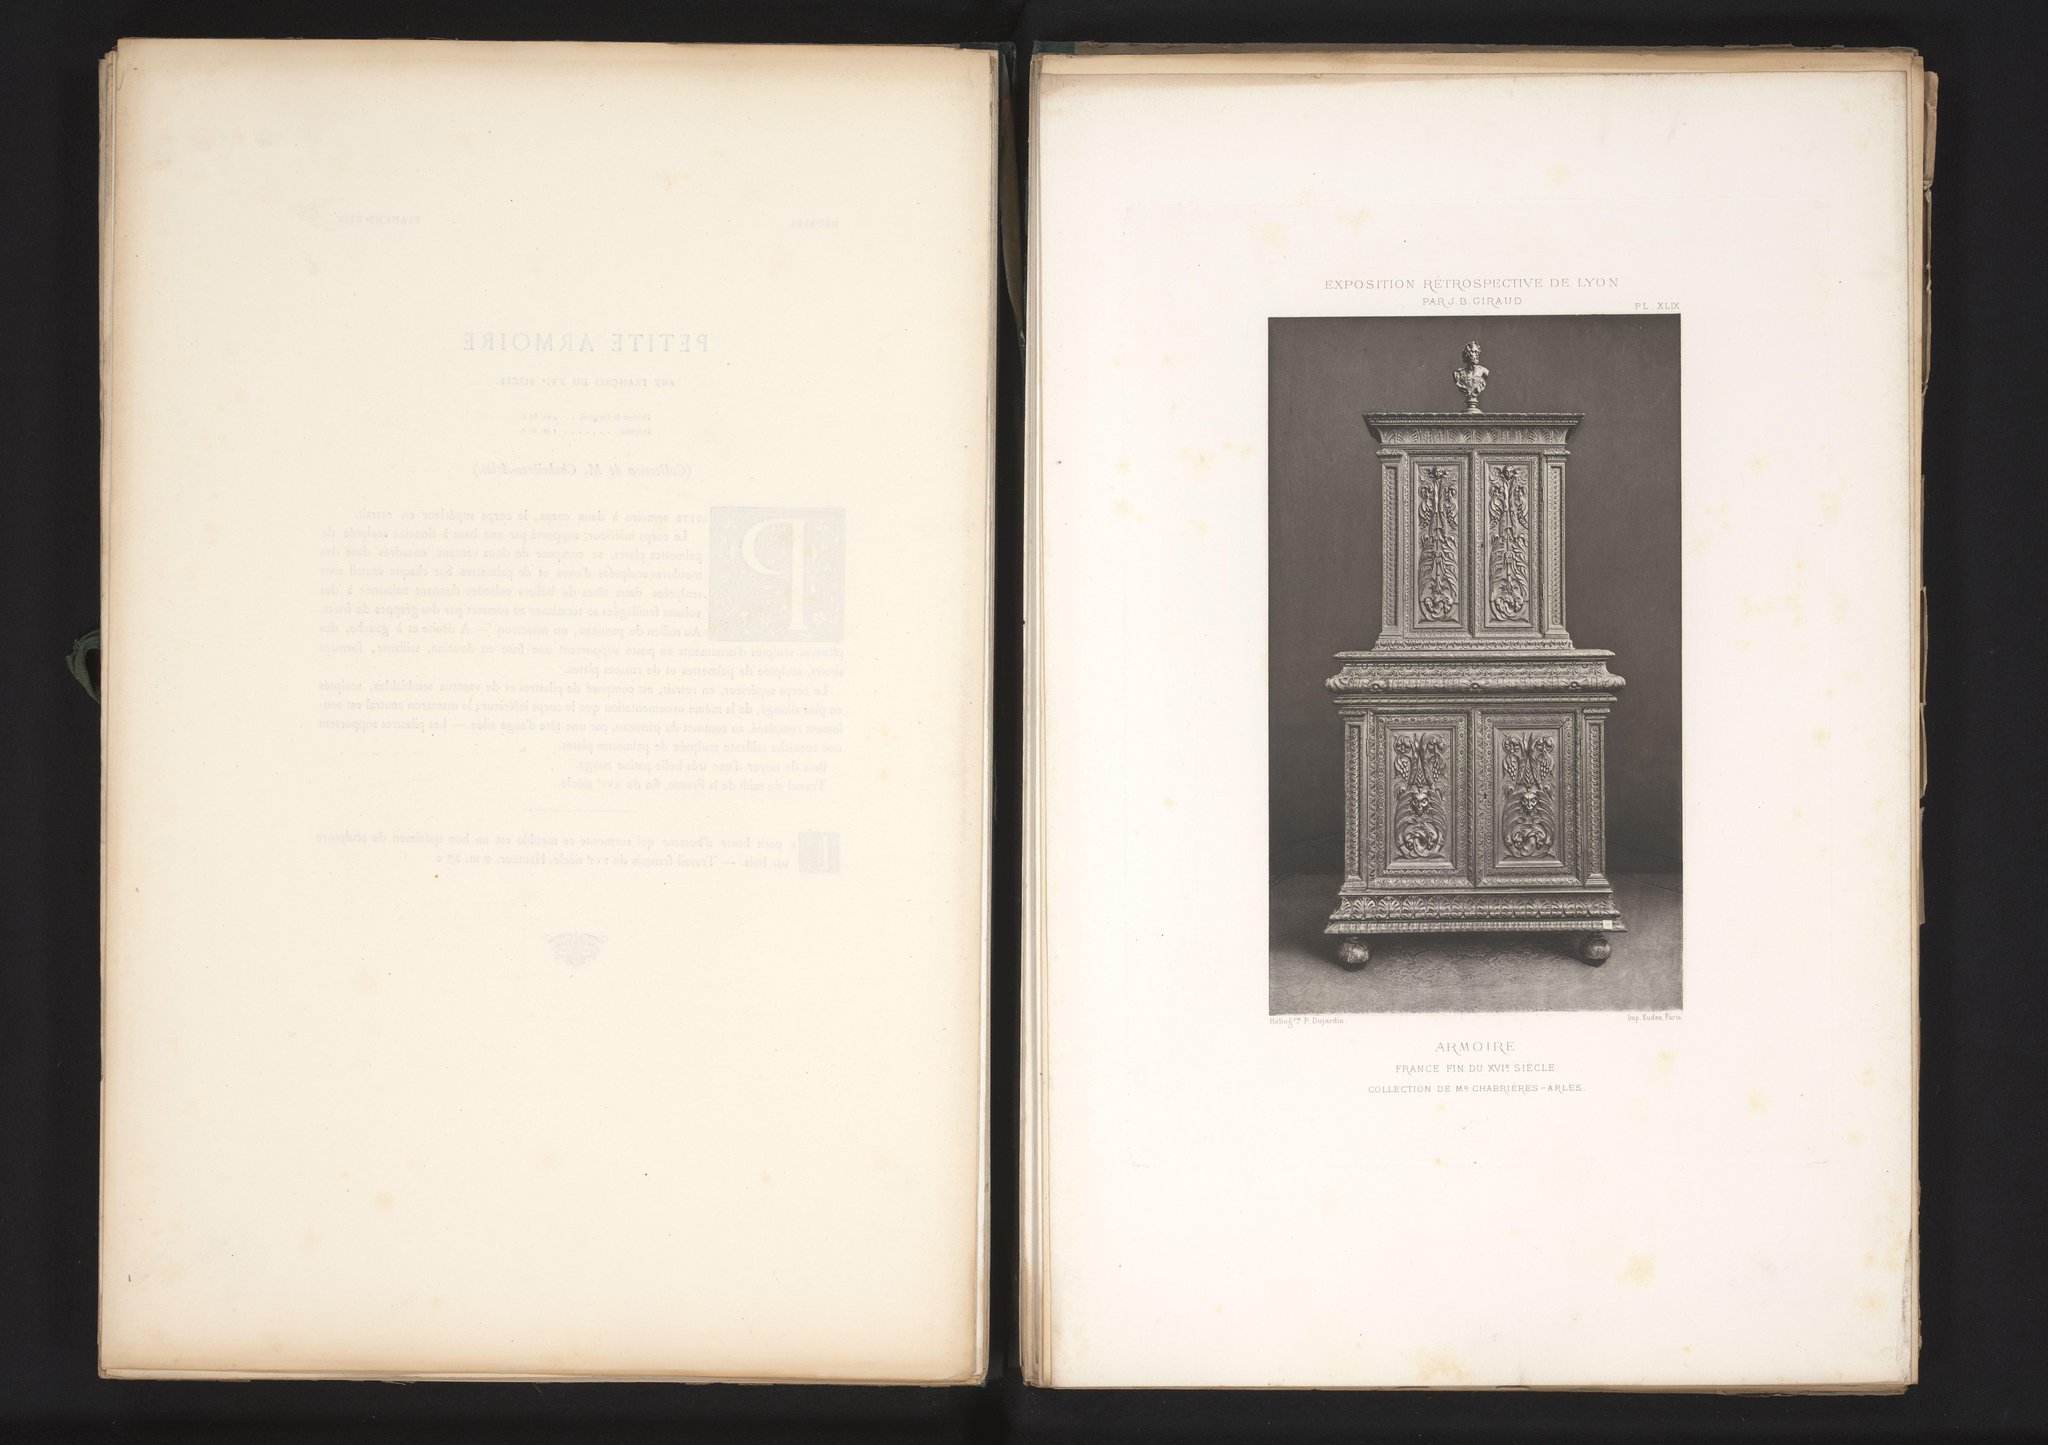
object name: photomechanical print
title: Laat-16de-eeuwse Franse kast van hout, op de Exposition Rétrospective van 1877 in Lyon, Frankrijk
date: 1877-1878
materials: paper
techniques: photoaquatint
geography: lyon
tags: ornamental cupboard (+ wood and other phytogenic material), lyon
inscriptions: inscription: ‘ARMOIRE/ FRANCE FIN DU XVIe SIÈCLE/ COLLECTION DE Mr CHABRIÈRES-ARLES.’, number: ‘PL. XLIX.’, inscription: ‘EXPOSITION RÉTROSPECTIVE DE LYON/ PAR J. B. GIRAUD.’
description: Deze prent maakt deel uit van een omslag met 79 prenten op 54 bladen en 65 tekstbladen.